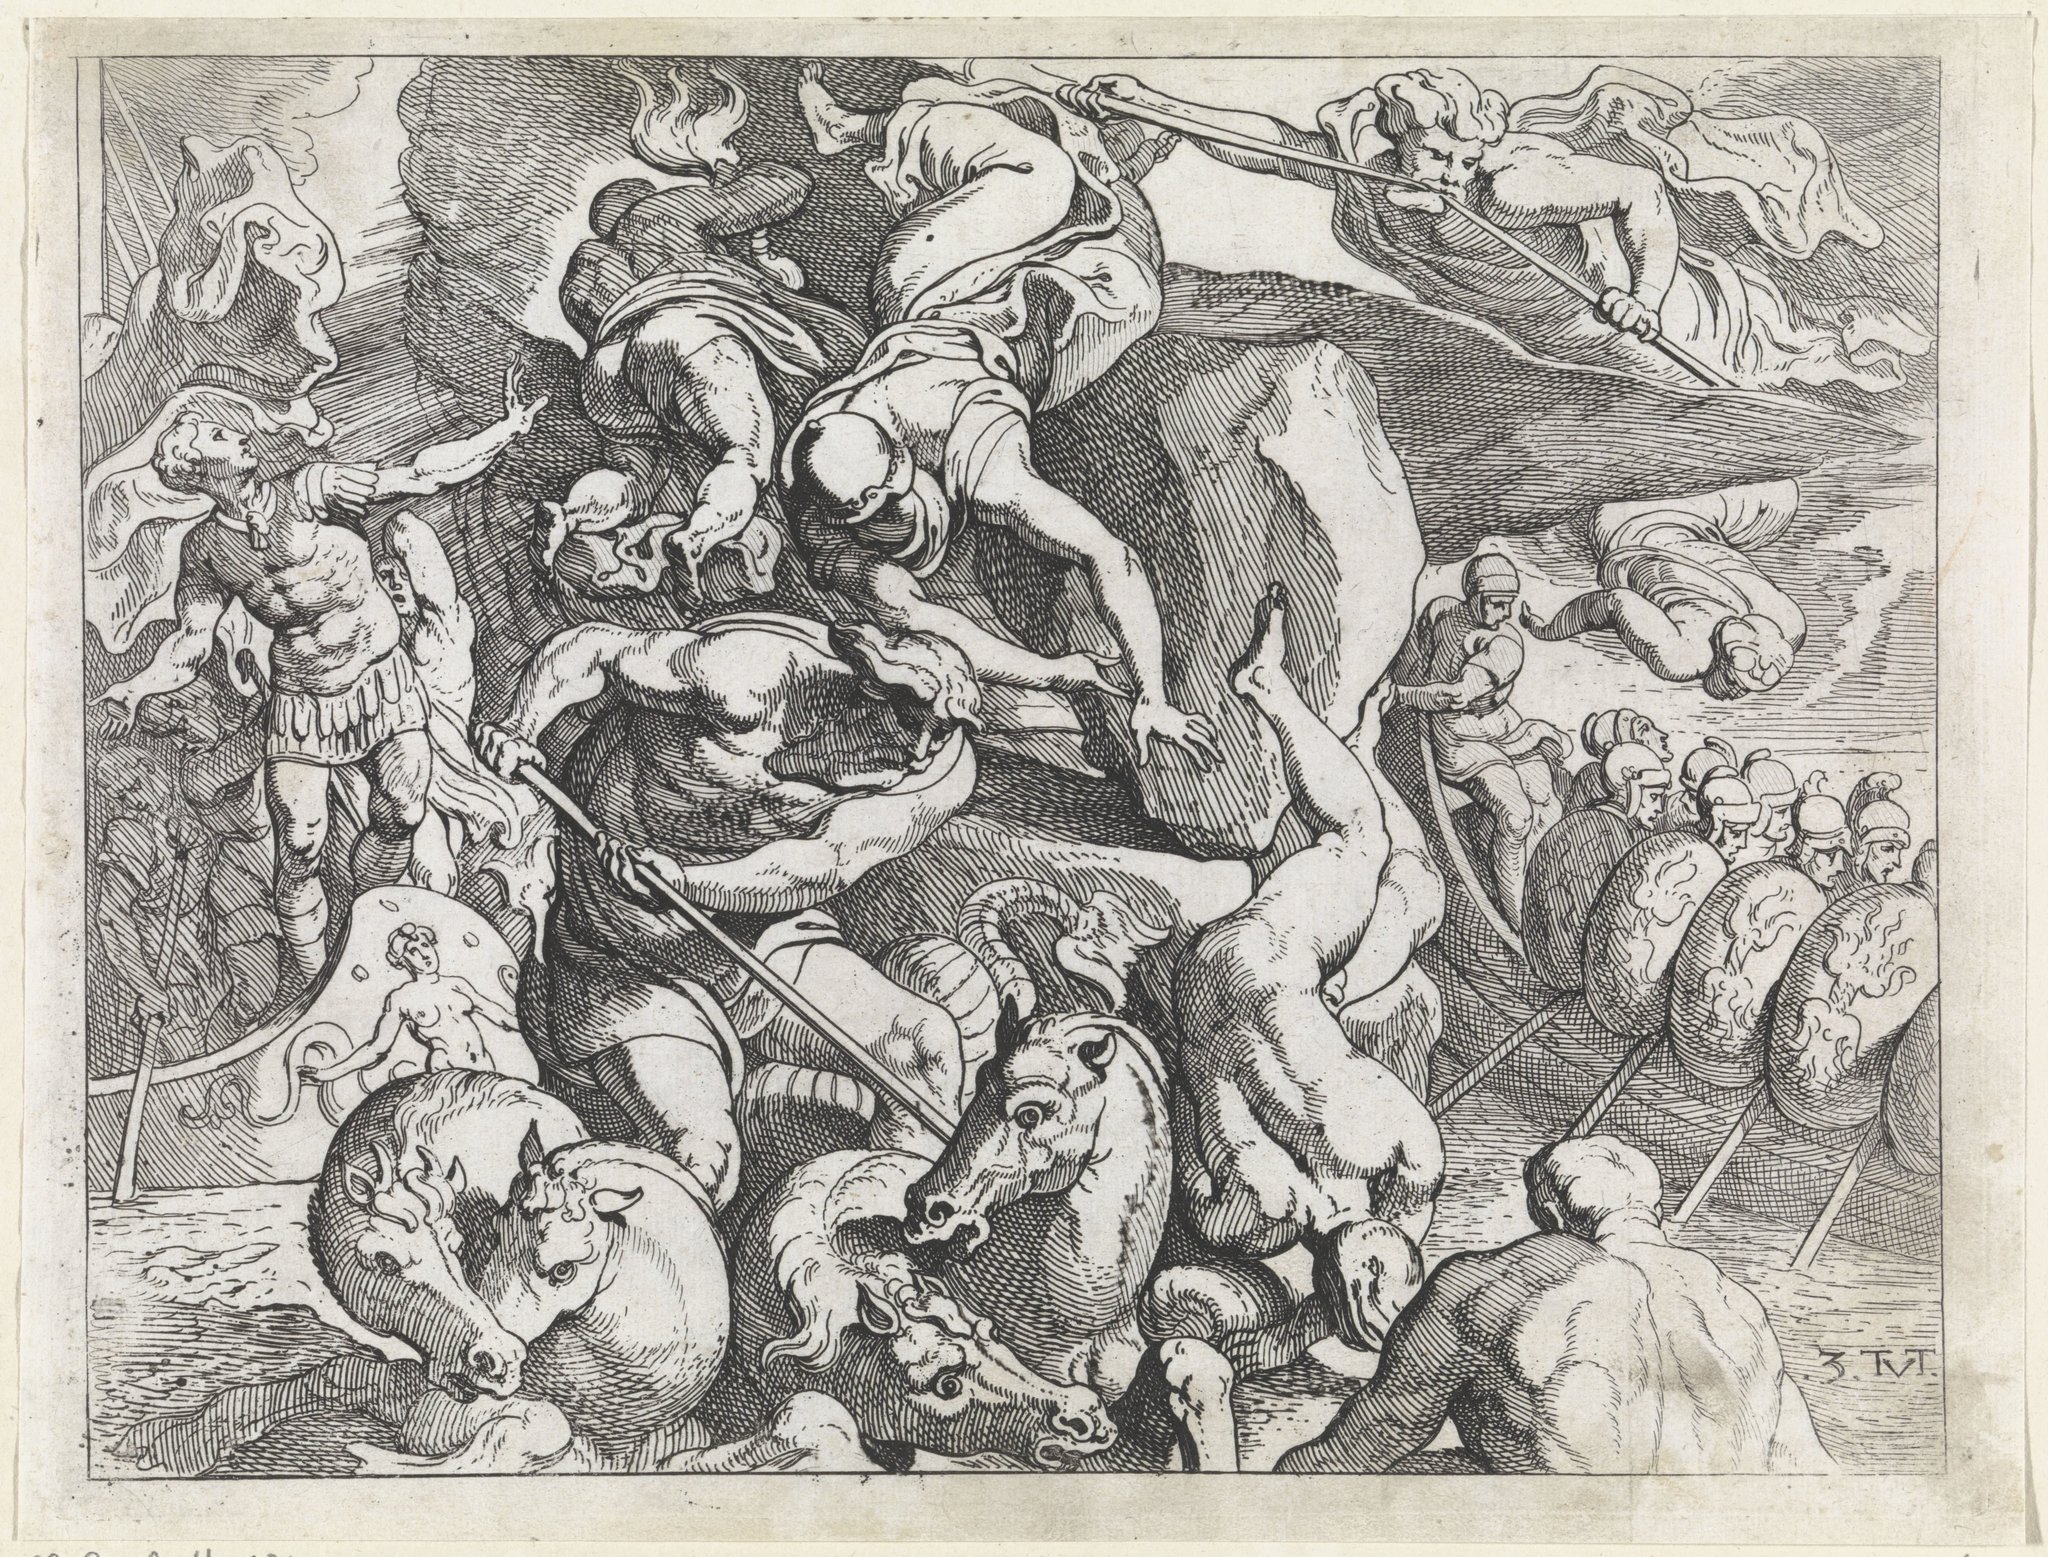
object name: print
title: De werken van Odysseus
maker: theodoor van thulden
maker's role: draughtsman, painter, print maker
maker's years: 1606-1669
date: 1632-1633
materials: paper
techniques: engraving, etching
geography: paris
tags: neptune raises a storm and destroys ulysses' raft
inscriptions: collector's mark: Lugt 2228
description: Neptunus wakkert een storm aan. Hij jaagt zijn paarden aan door hen te steken met zijn drietand. Rechtsboven blaast een windgod de wind aan. Uit de hemel vallen Jupiter met bliksemschicht en Minerva met helm op het hoofd. Links kijkt Odysseus verschrikt toe. De schepen hebben het moeilijk.